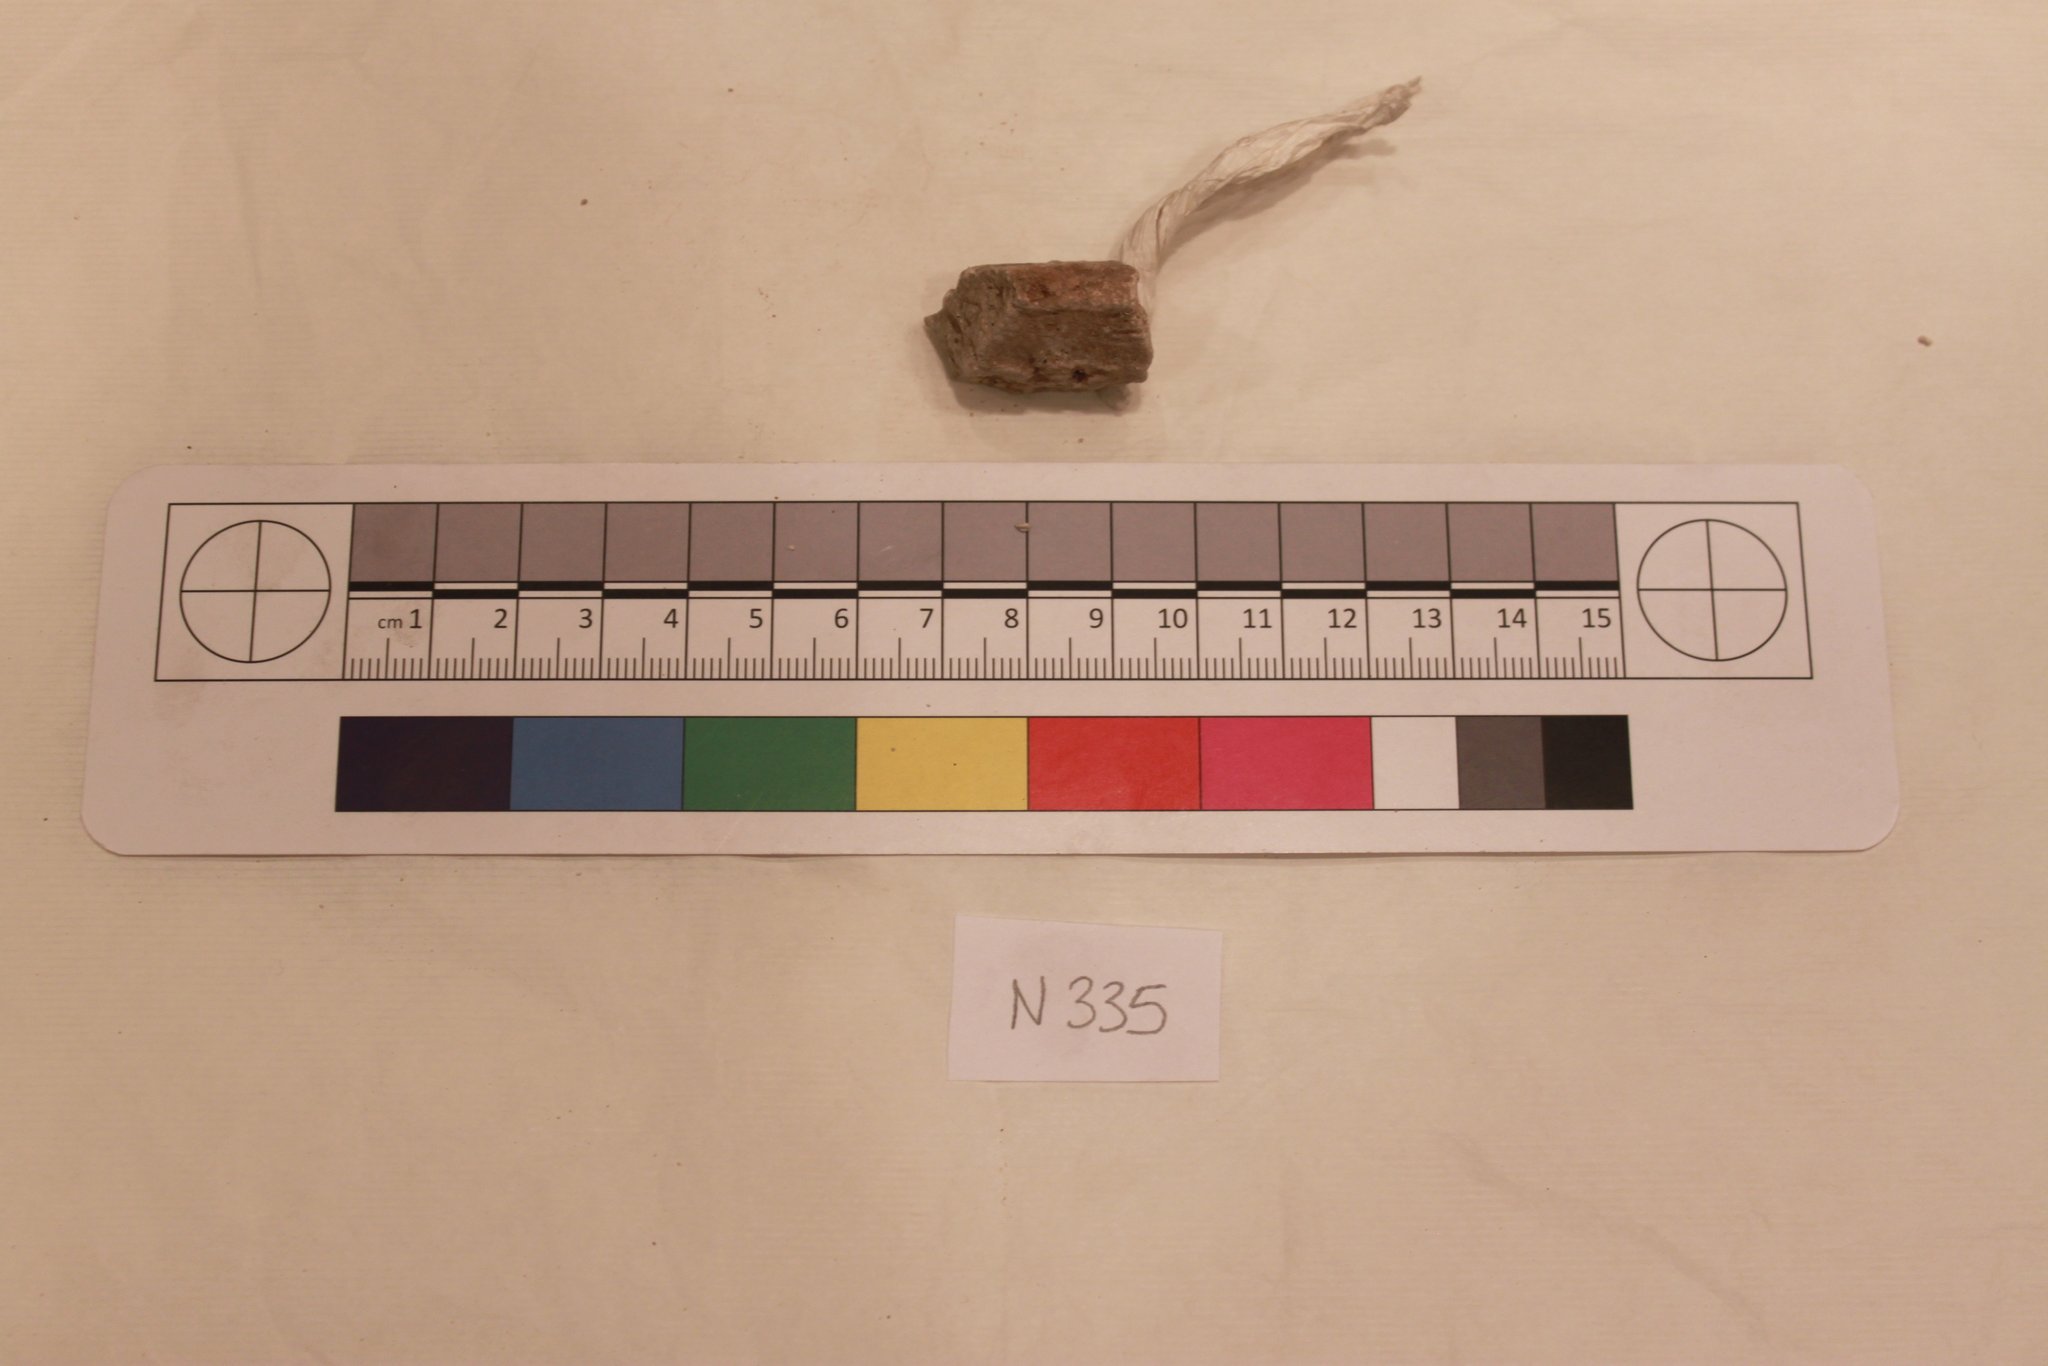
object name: fragment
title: Stucco Fragment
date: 701-1200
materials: plaster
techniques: carving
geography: iran